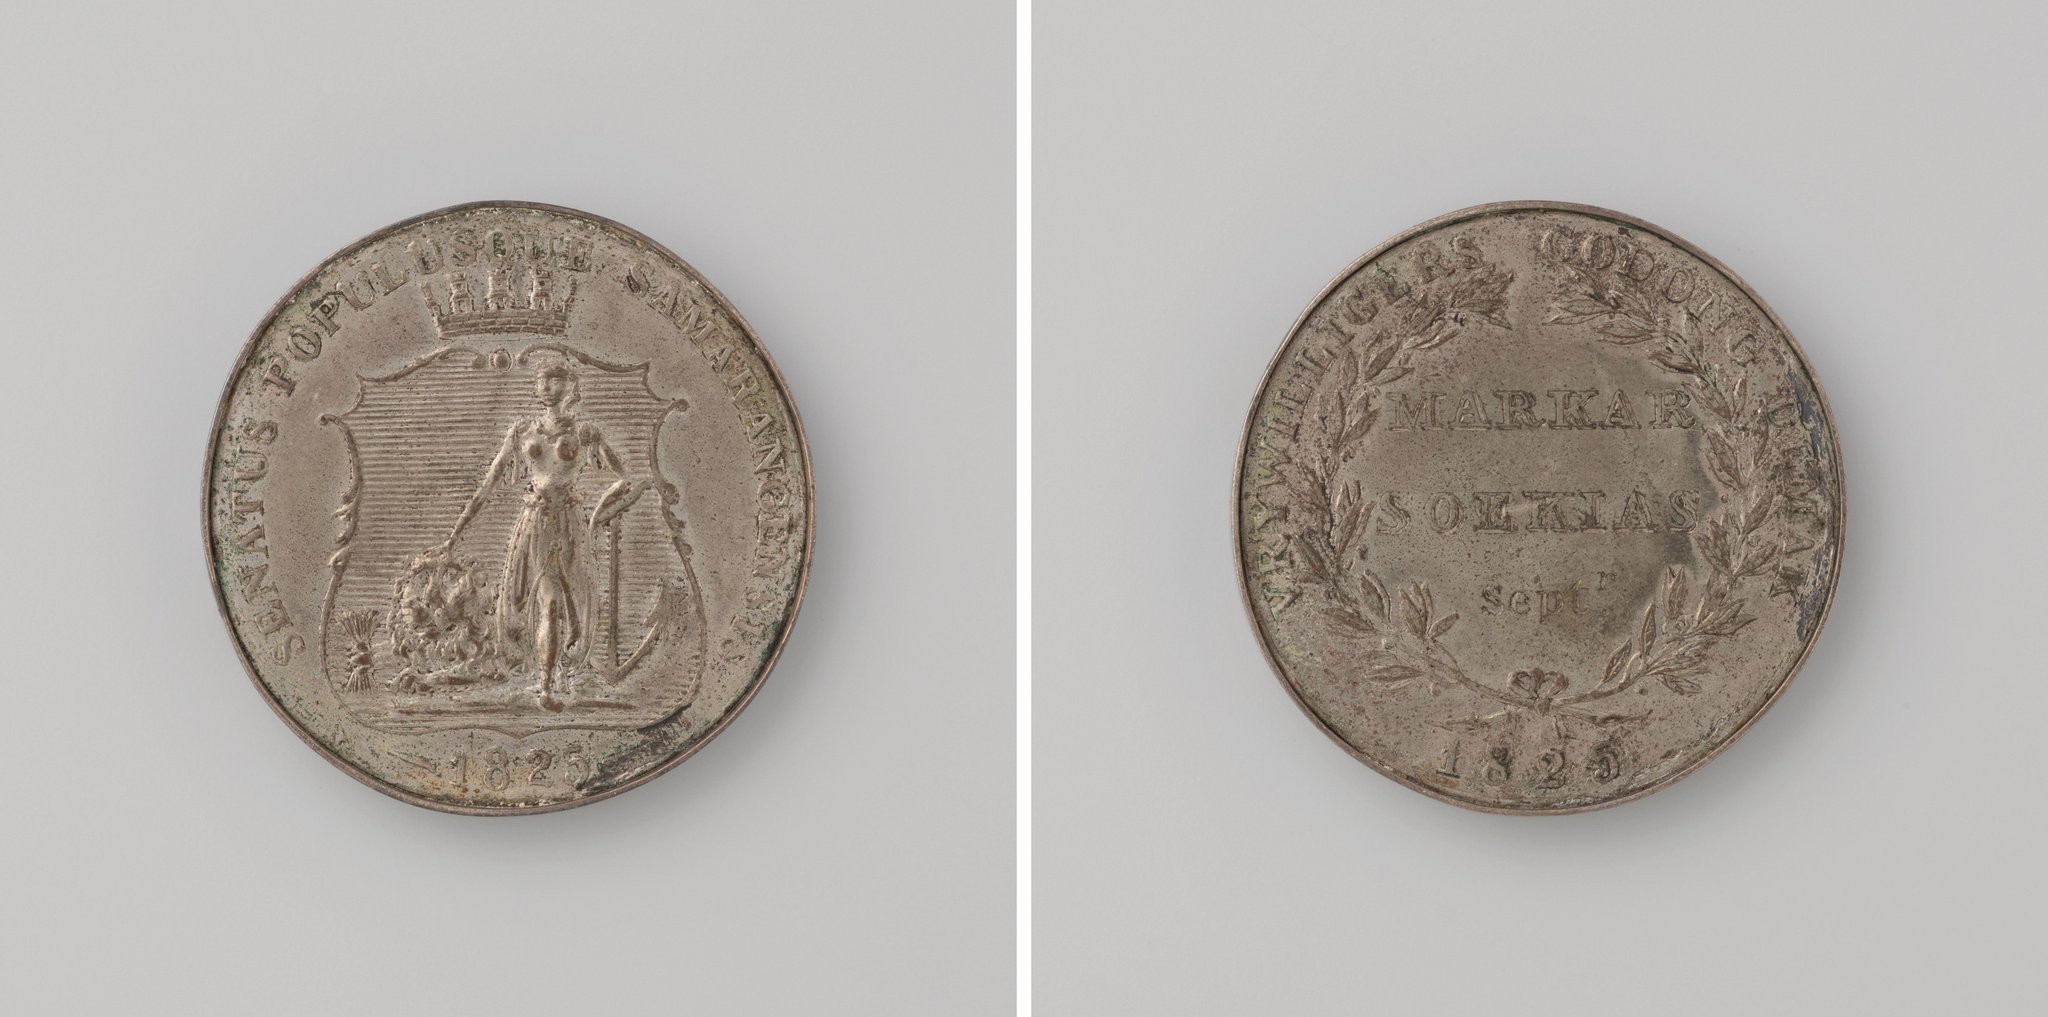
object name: honorary medal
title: De Semarangse schutters en vrijwilligers die bij Gedoeng Demak hebben gevochten, penning geschonken door bestuur en inwoners van Semarang, op naam van Markar Soekias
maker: Anonymous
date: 1809-1825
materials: silver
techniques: engraving, striking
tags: isfahan, jepara, militair, markar soekias (margar sookiasian), gedong demak, semarang, strijd bij gedong demak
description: Zilveren penning. Voorzijde: gekroond wapenschild binnen omschrift. Keerzijde: opschrift binnen lauwerkrans en omschrift.